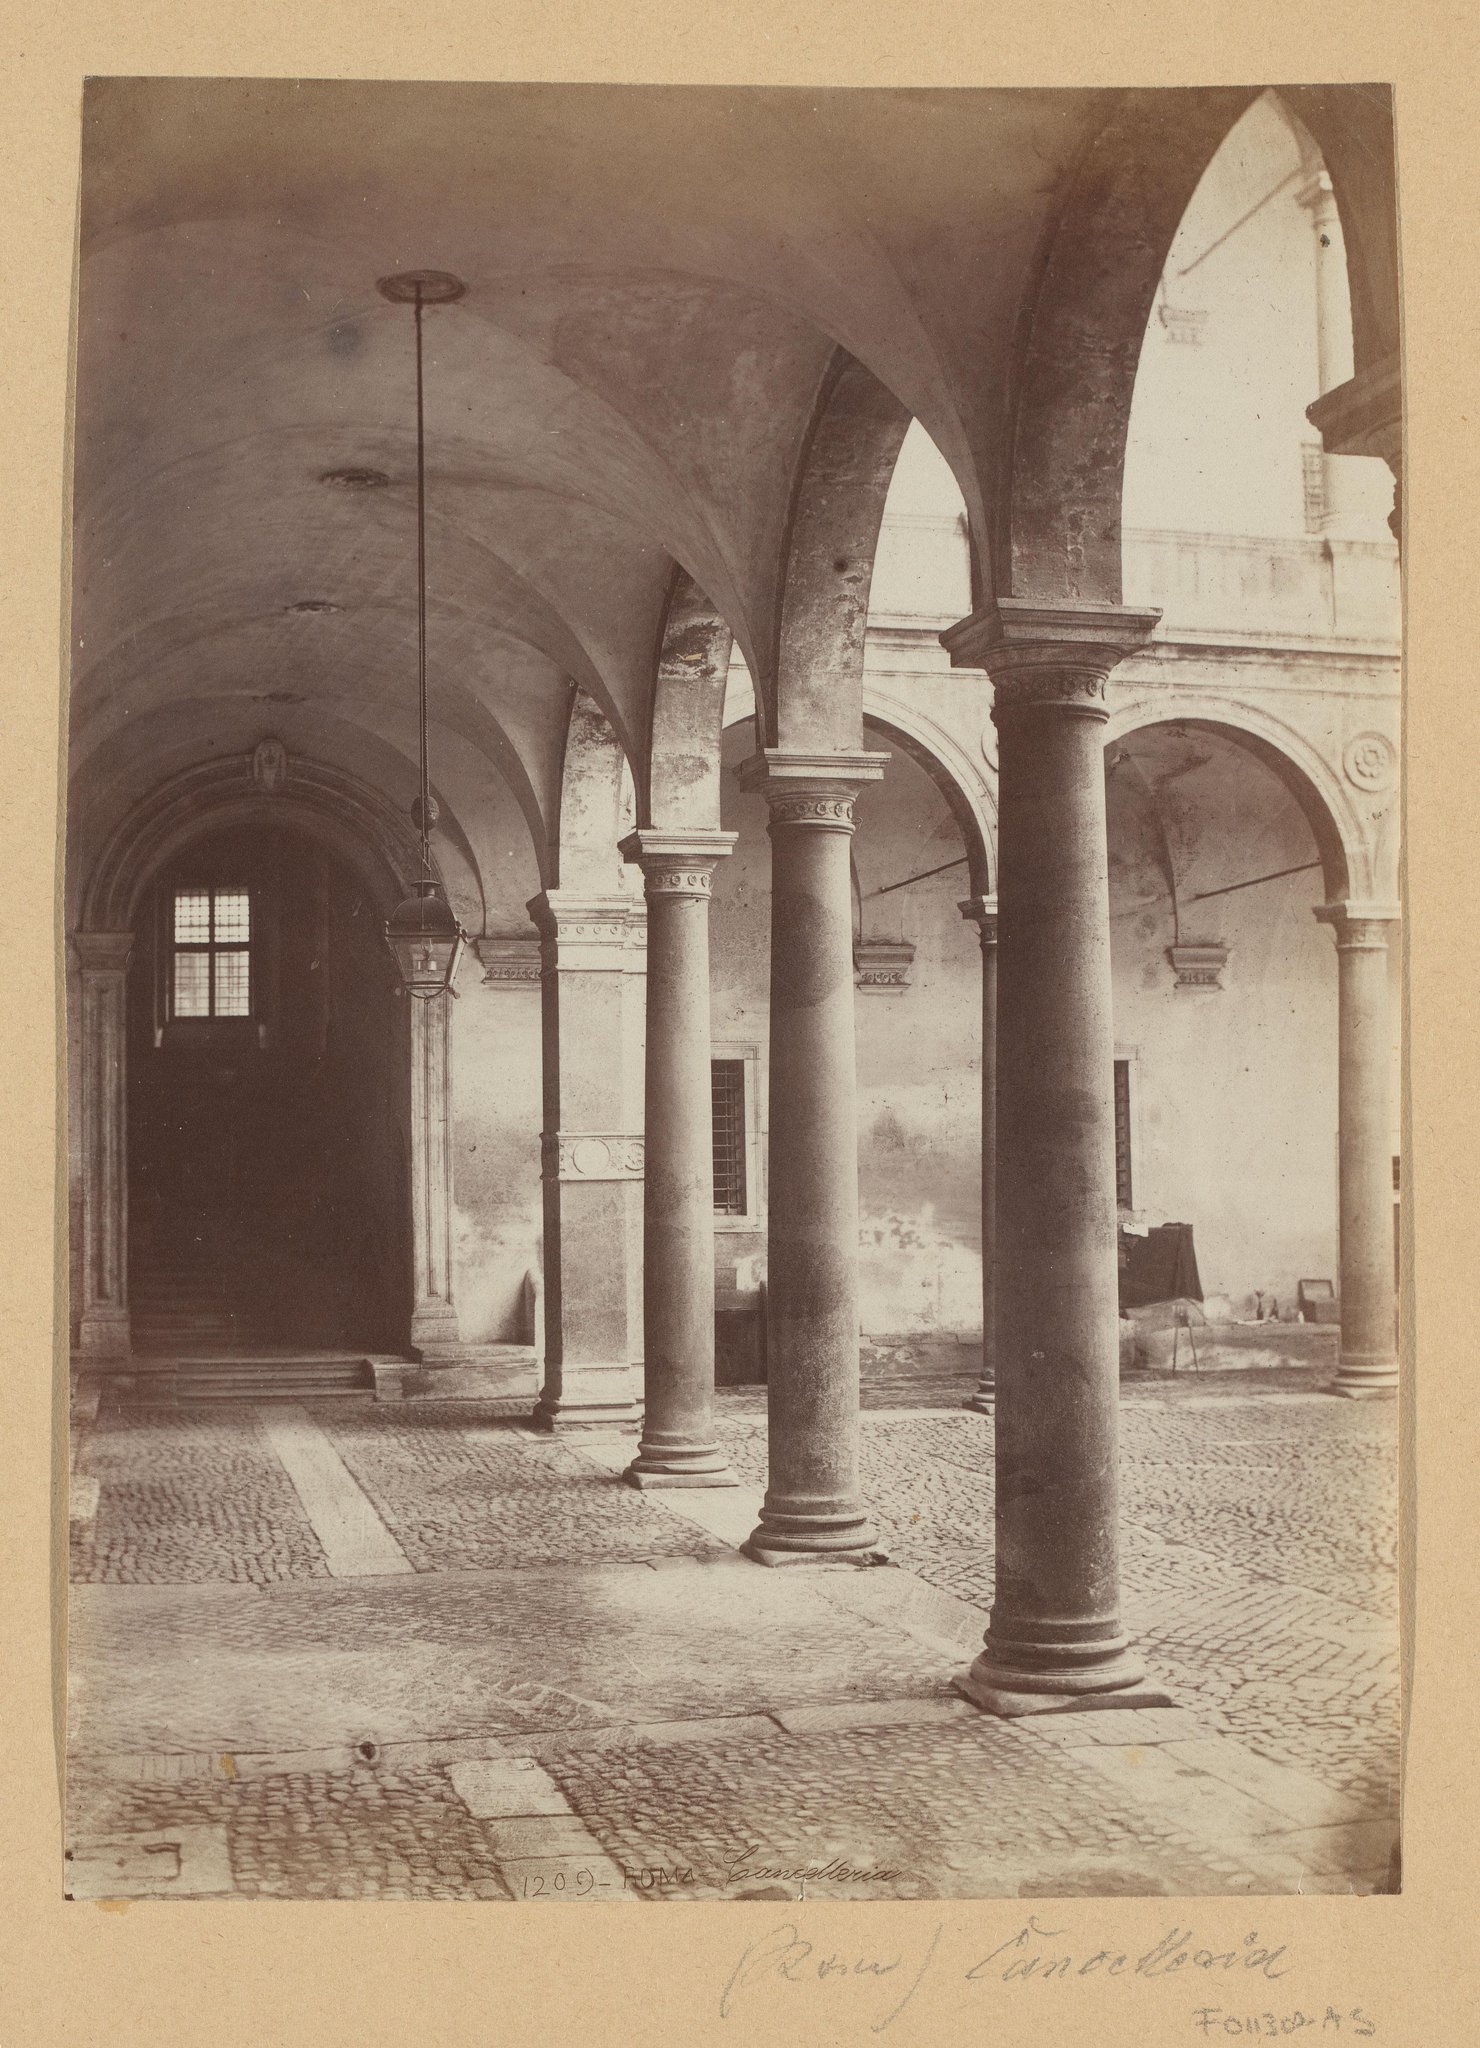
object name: photograph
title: Roma Cancelleria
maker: Anonymous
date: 1860-1900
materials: photographic support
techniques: albumen print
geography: palazzo della cancelleria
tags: colonnade, palace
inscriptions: number: ‘1209’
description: Onderdeel van Reisalbum met opnames van kunstwerken en bezienswaardigheden in Italië, Griekenland en Frankrijk.